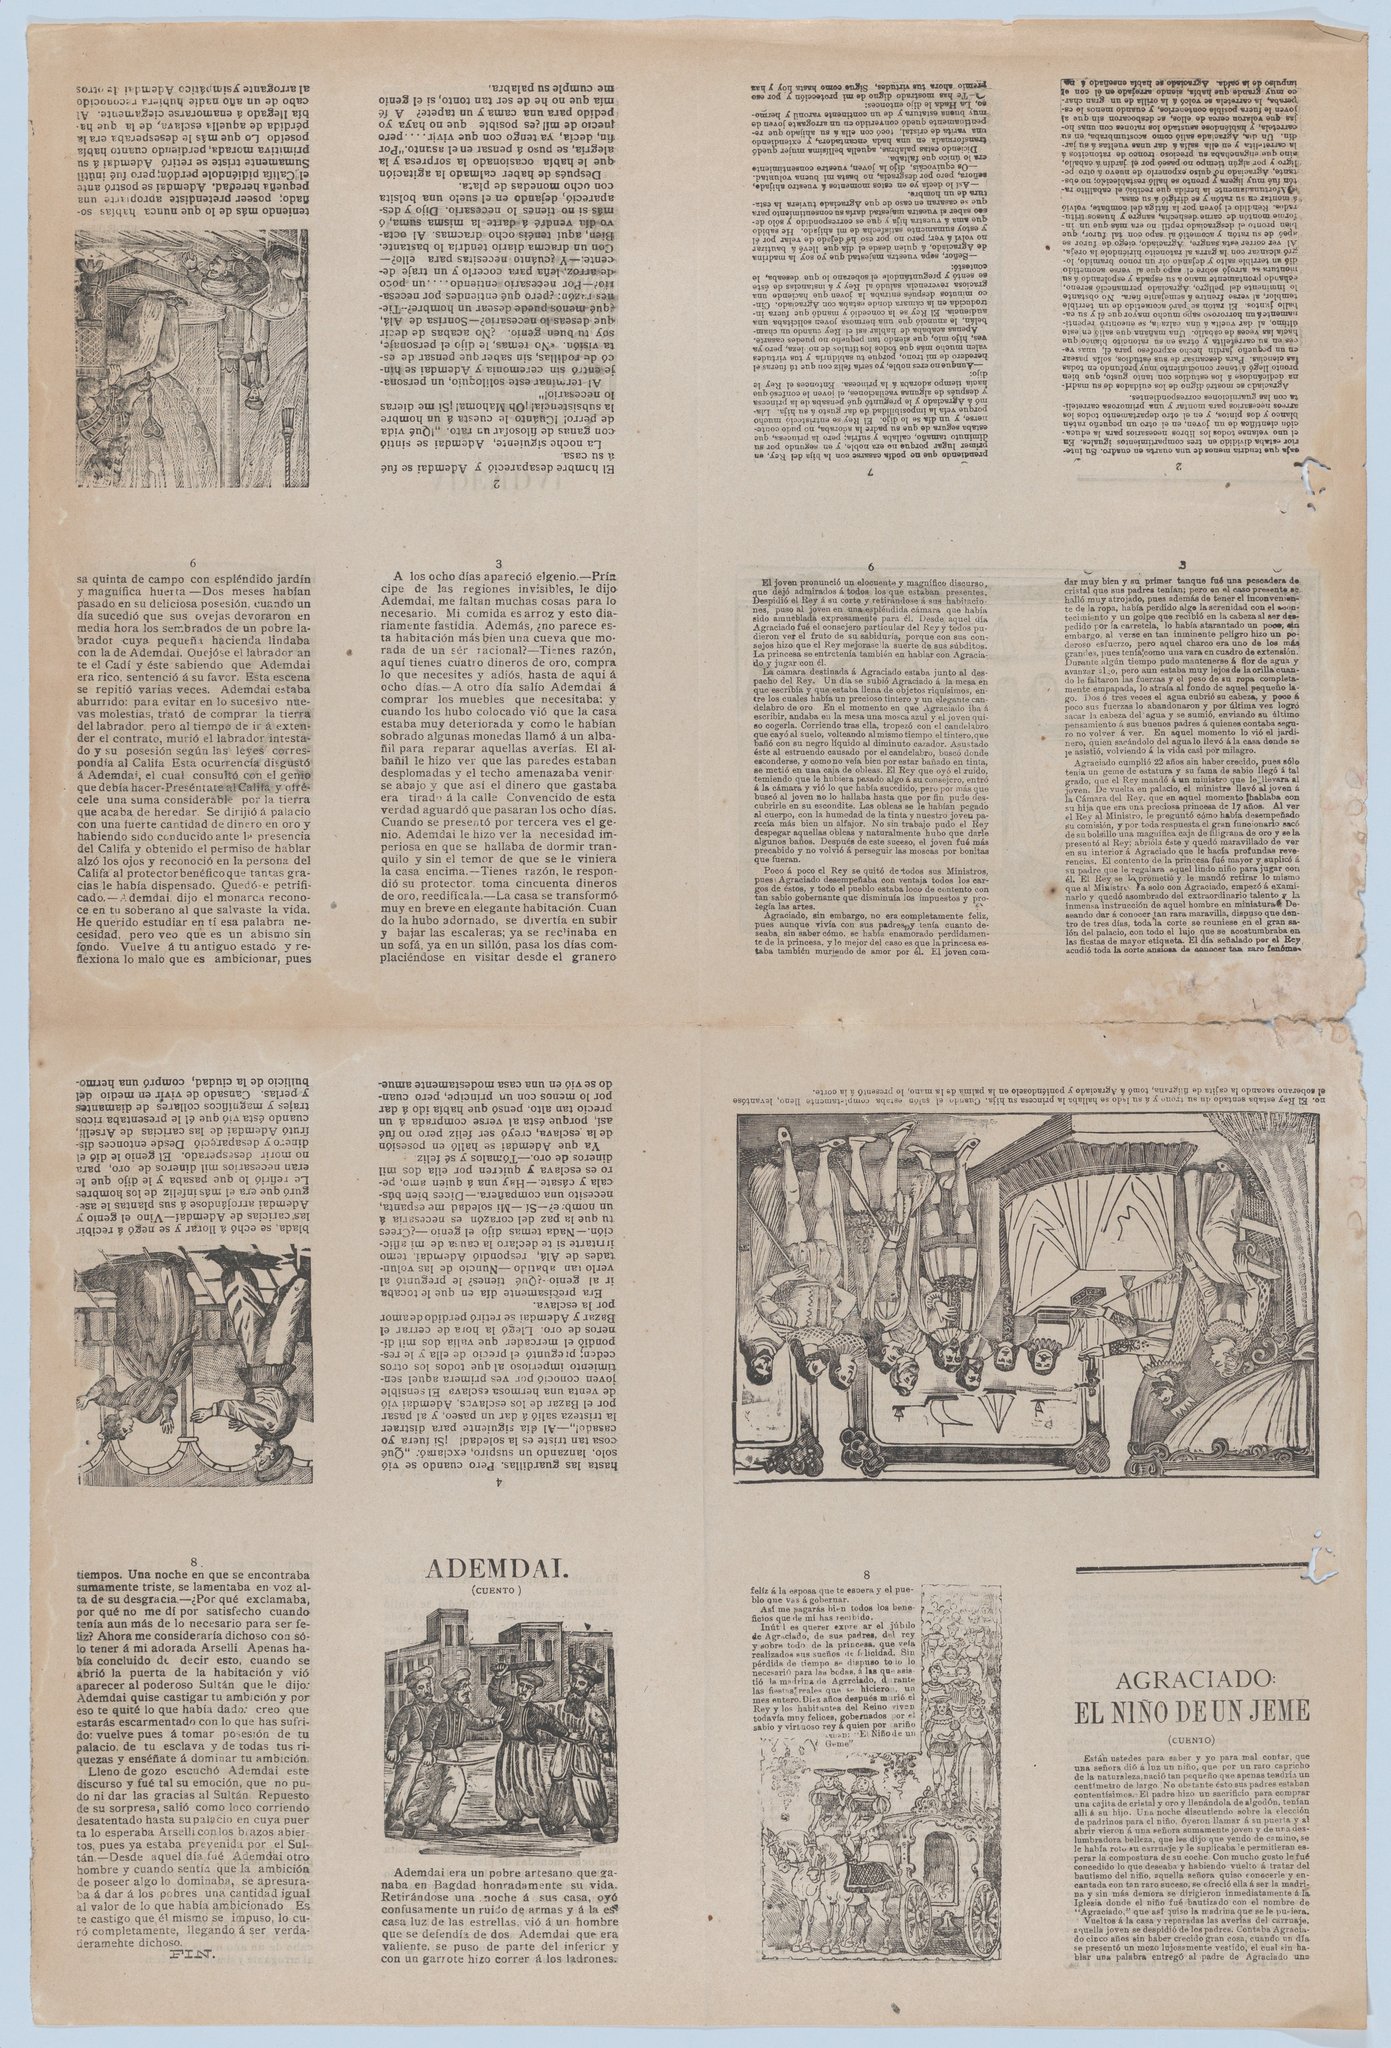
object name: print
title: An uncut sheet printed on both sides with pages from "Ademdai" and "Agraciado: El niño de un jeme"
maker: josé guadalupe posada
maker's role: artist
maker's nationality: mexican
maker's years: 1852-1913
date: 1900-1910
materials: zinc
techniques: etching, letterpress, relief print